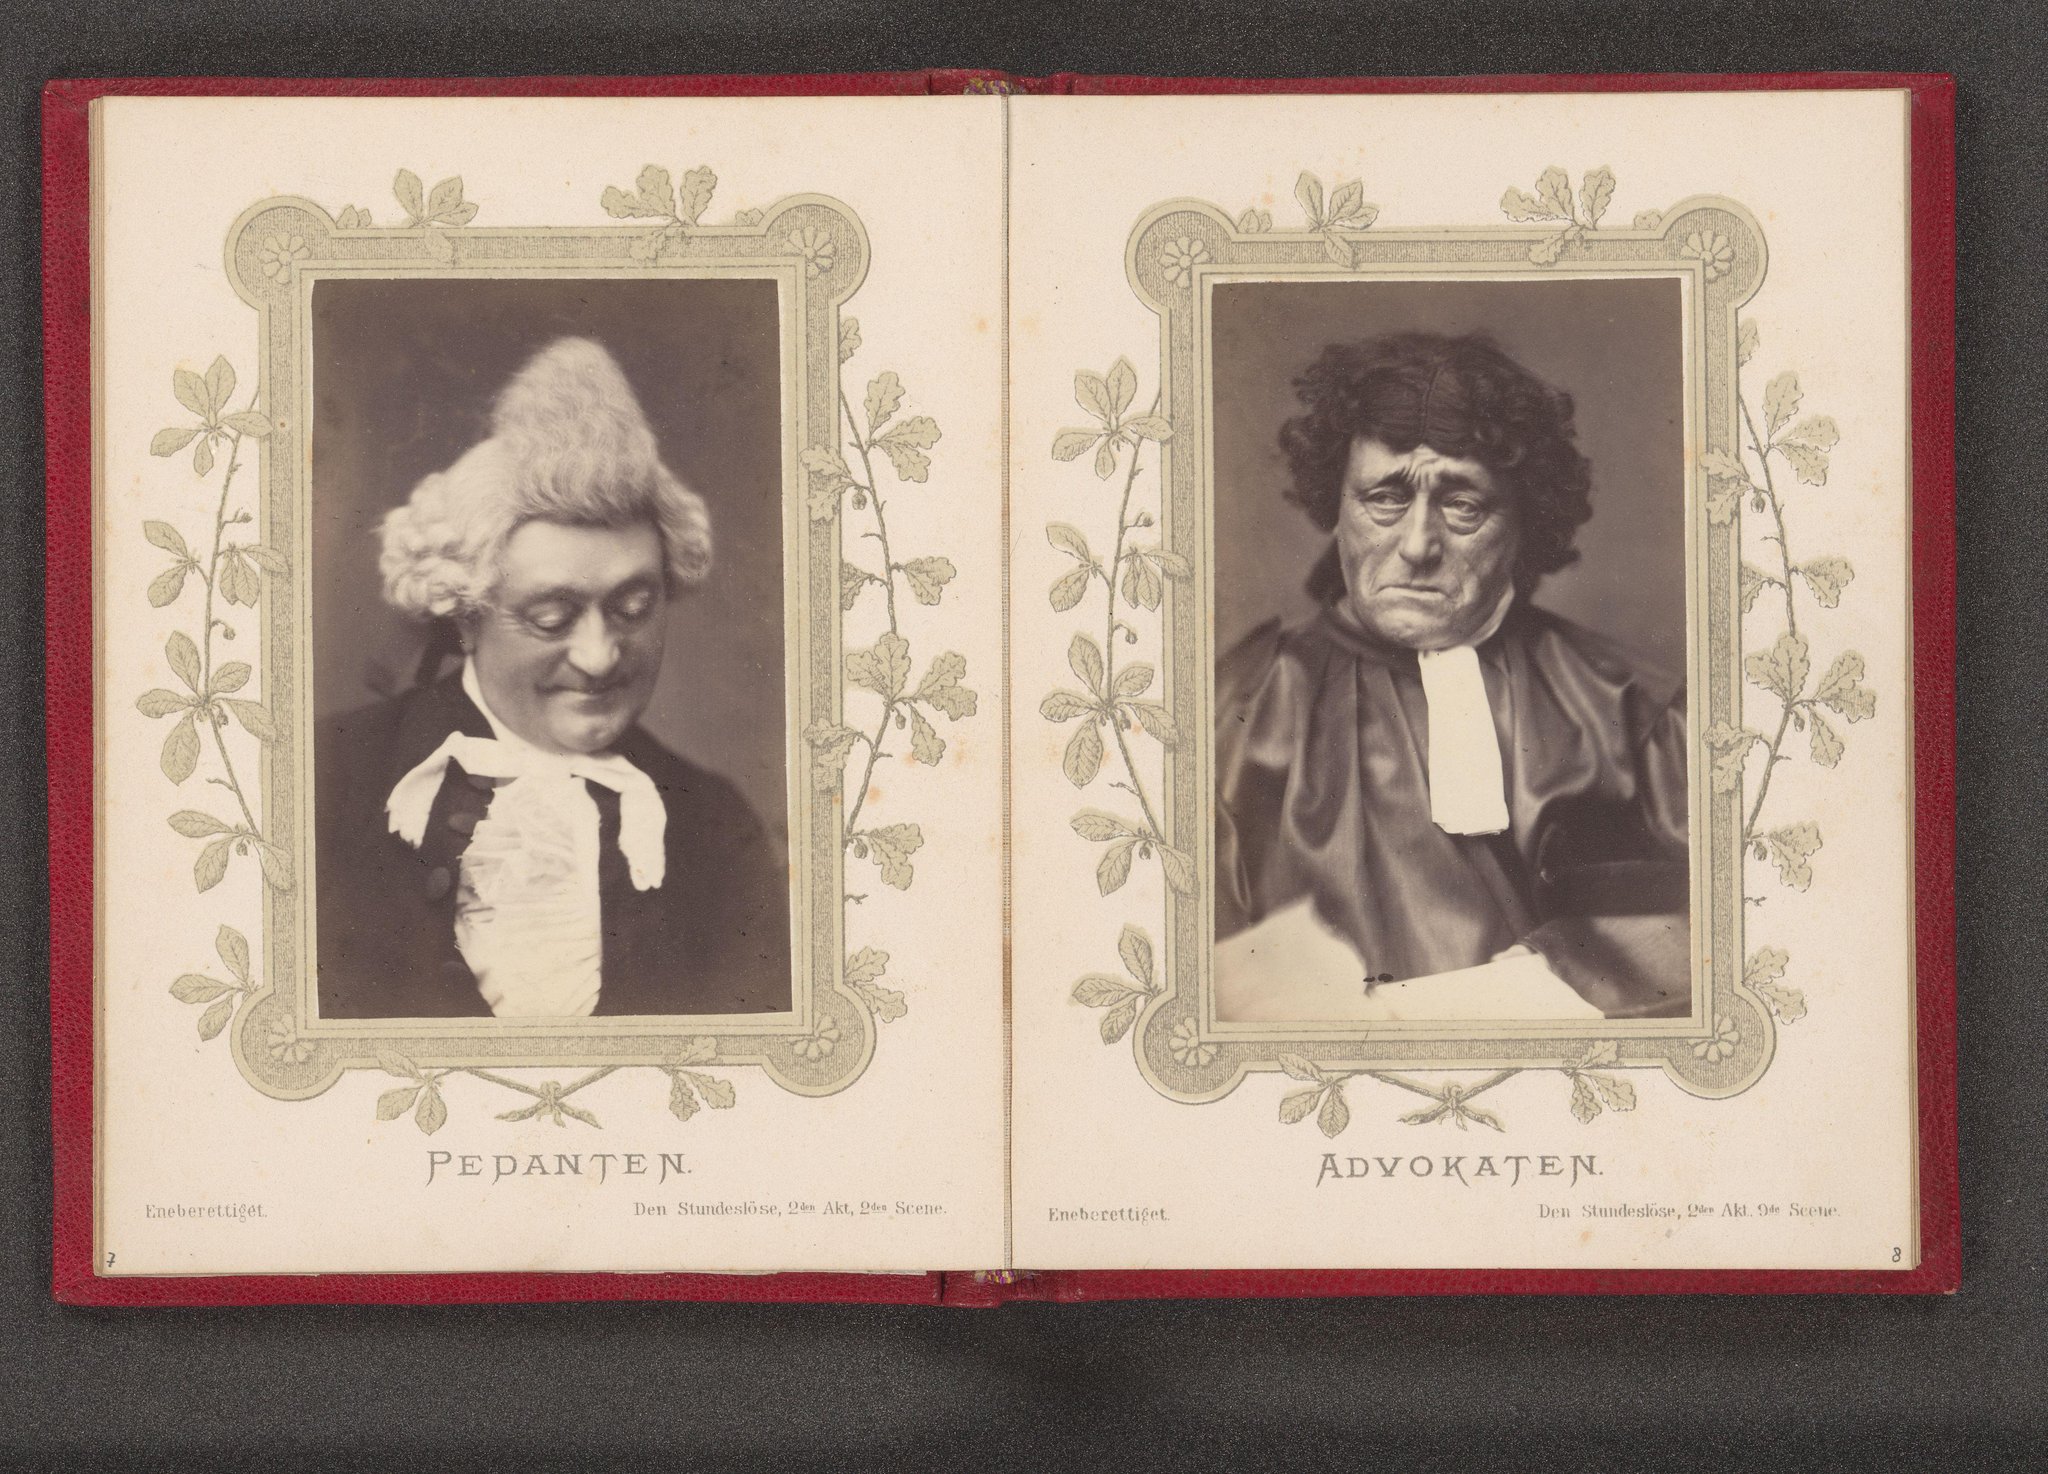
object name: page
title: Portret van Joachim Ludvig Phister als een advocaat uit Den Stundesløse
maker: harald paetz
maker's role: fotograaf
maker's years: 1837-1895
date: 1862-1872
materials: photographic support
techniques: albumen print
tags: stage costume, portrait of actor, actress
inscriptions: inscription: ‘Eneberettiget Den Stundeslöse. 2den Akt. 9de Scene.’